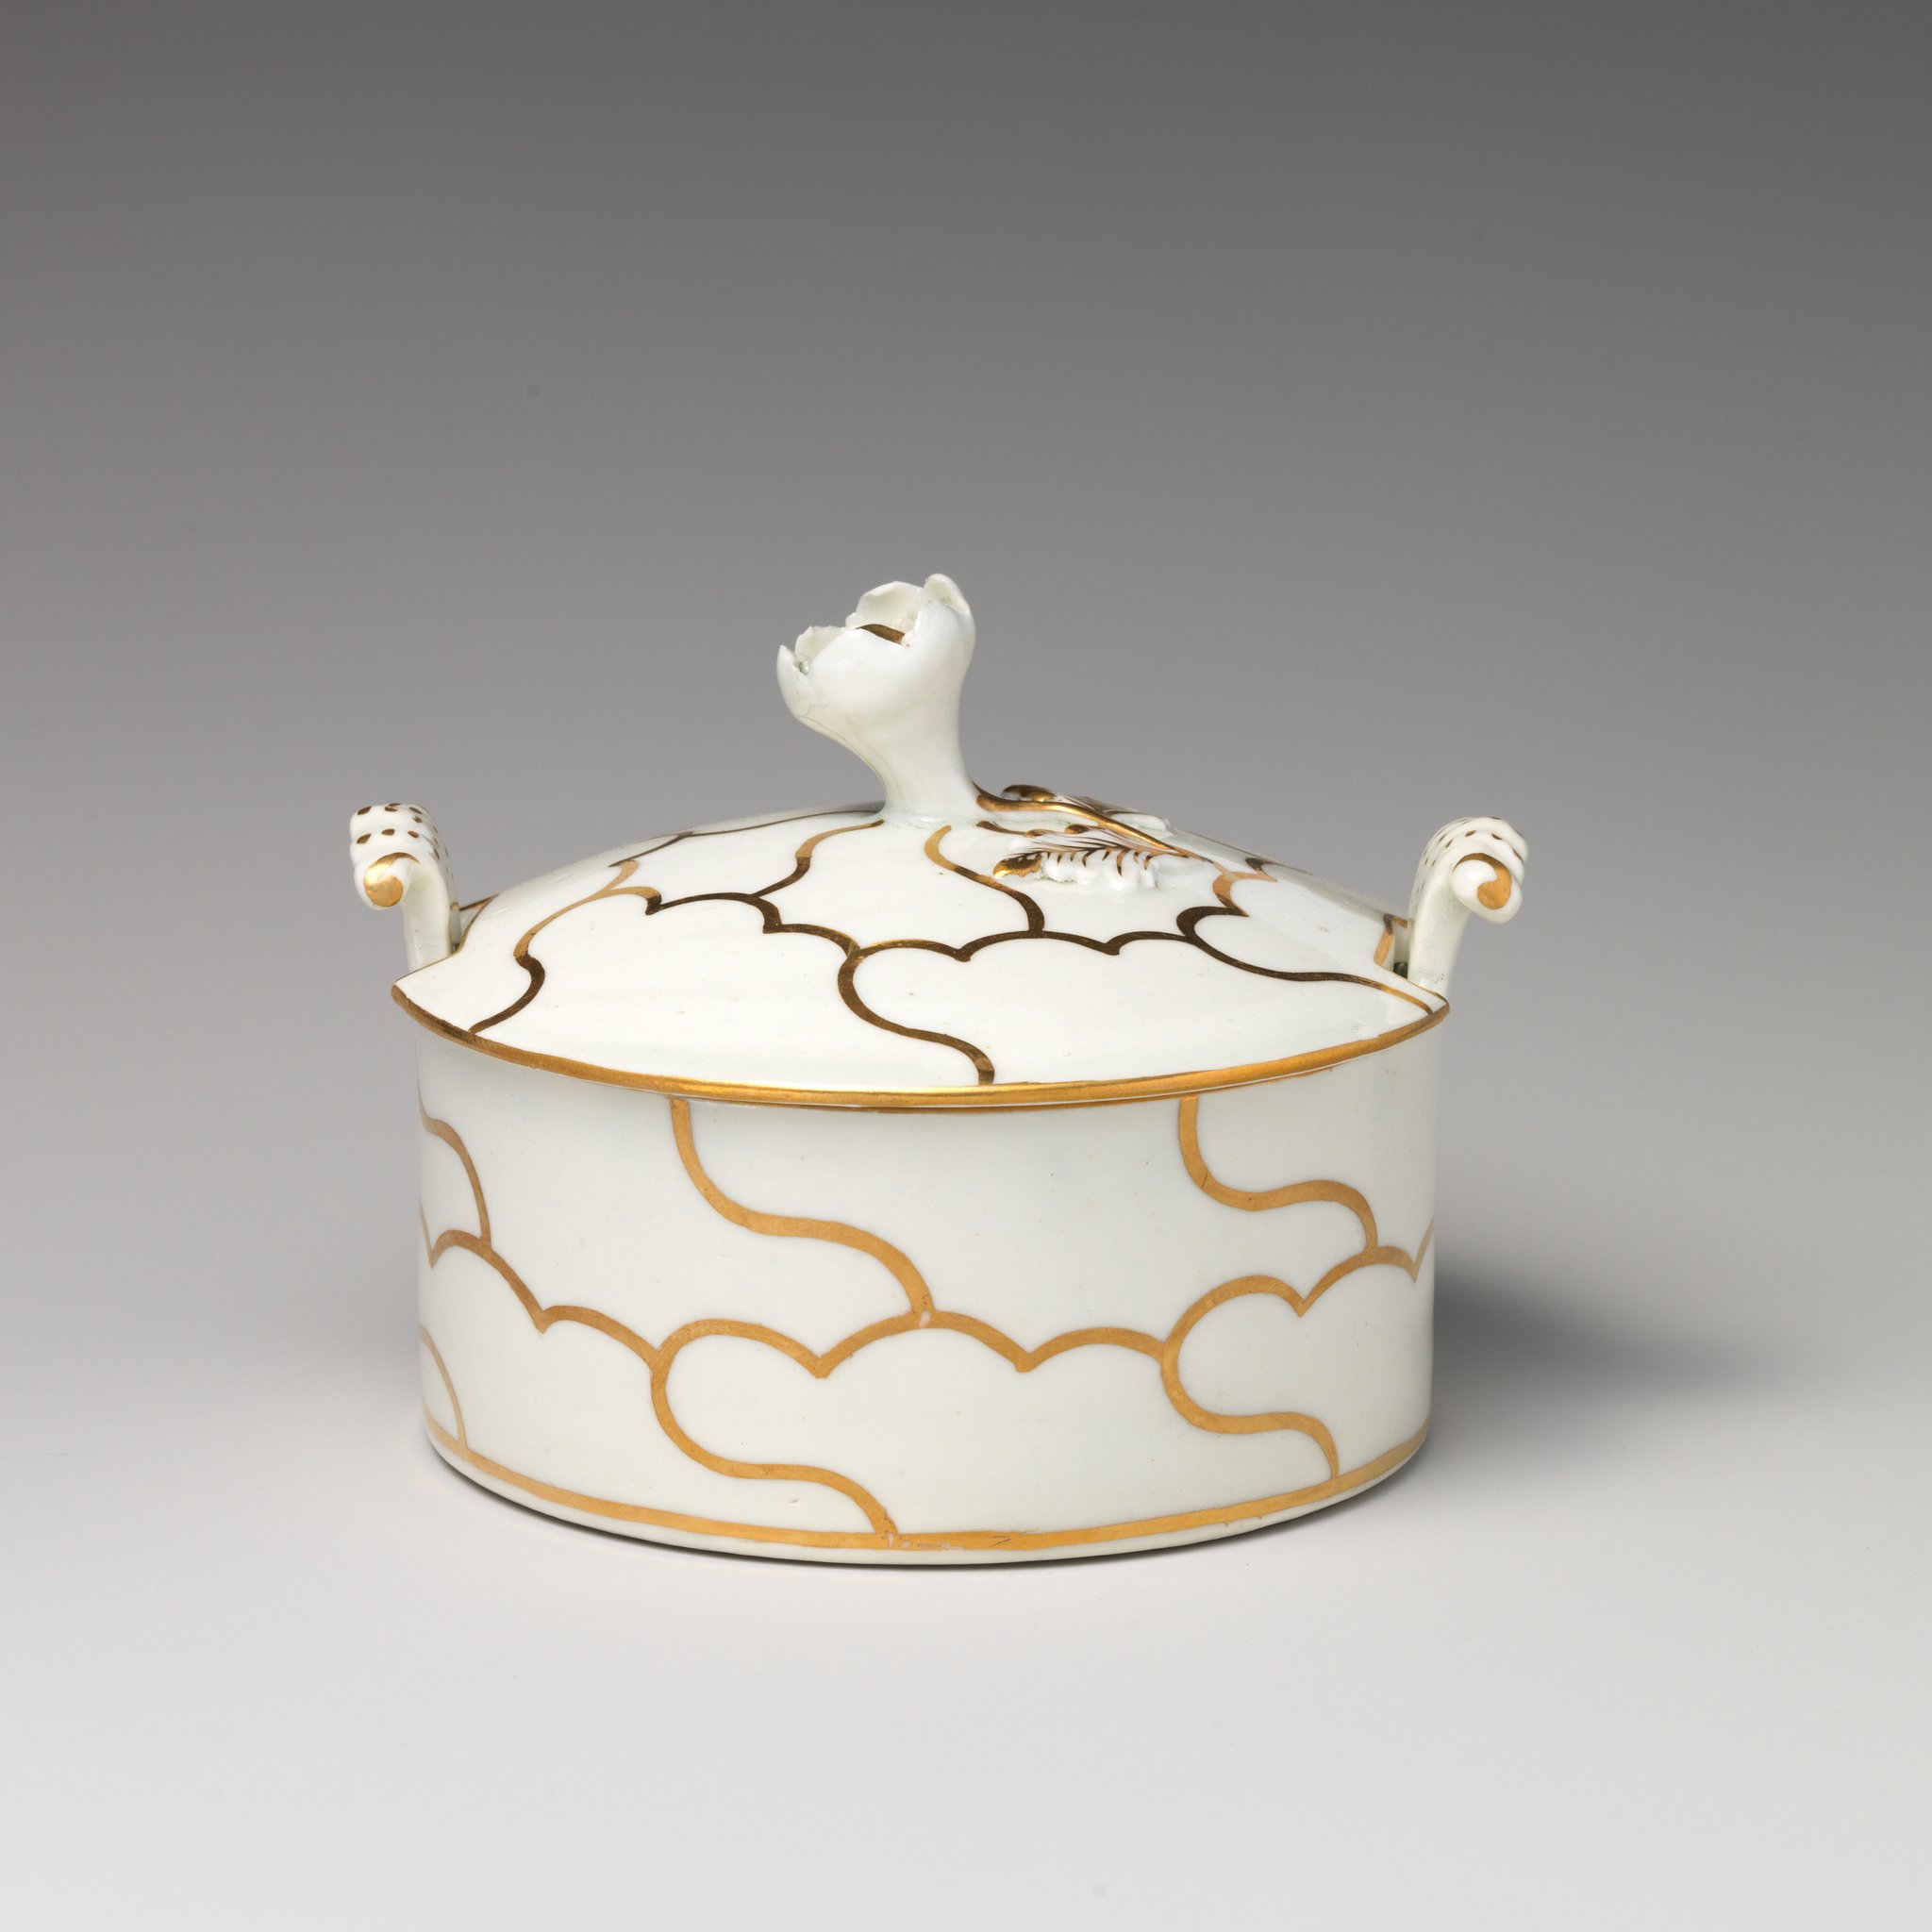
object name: butter dish with cover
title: Butter dish with cover (part of a service)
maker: worcester factory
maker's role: factory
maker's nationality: british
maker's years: 1751-2008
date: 1775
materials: soft paste porcelain